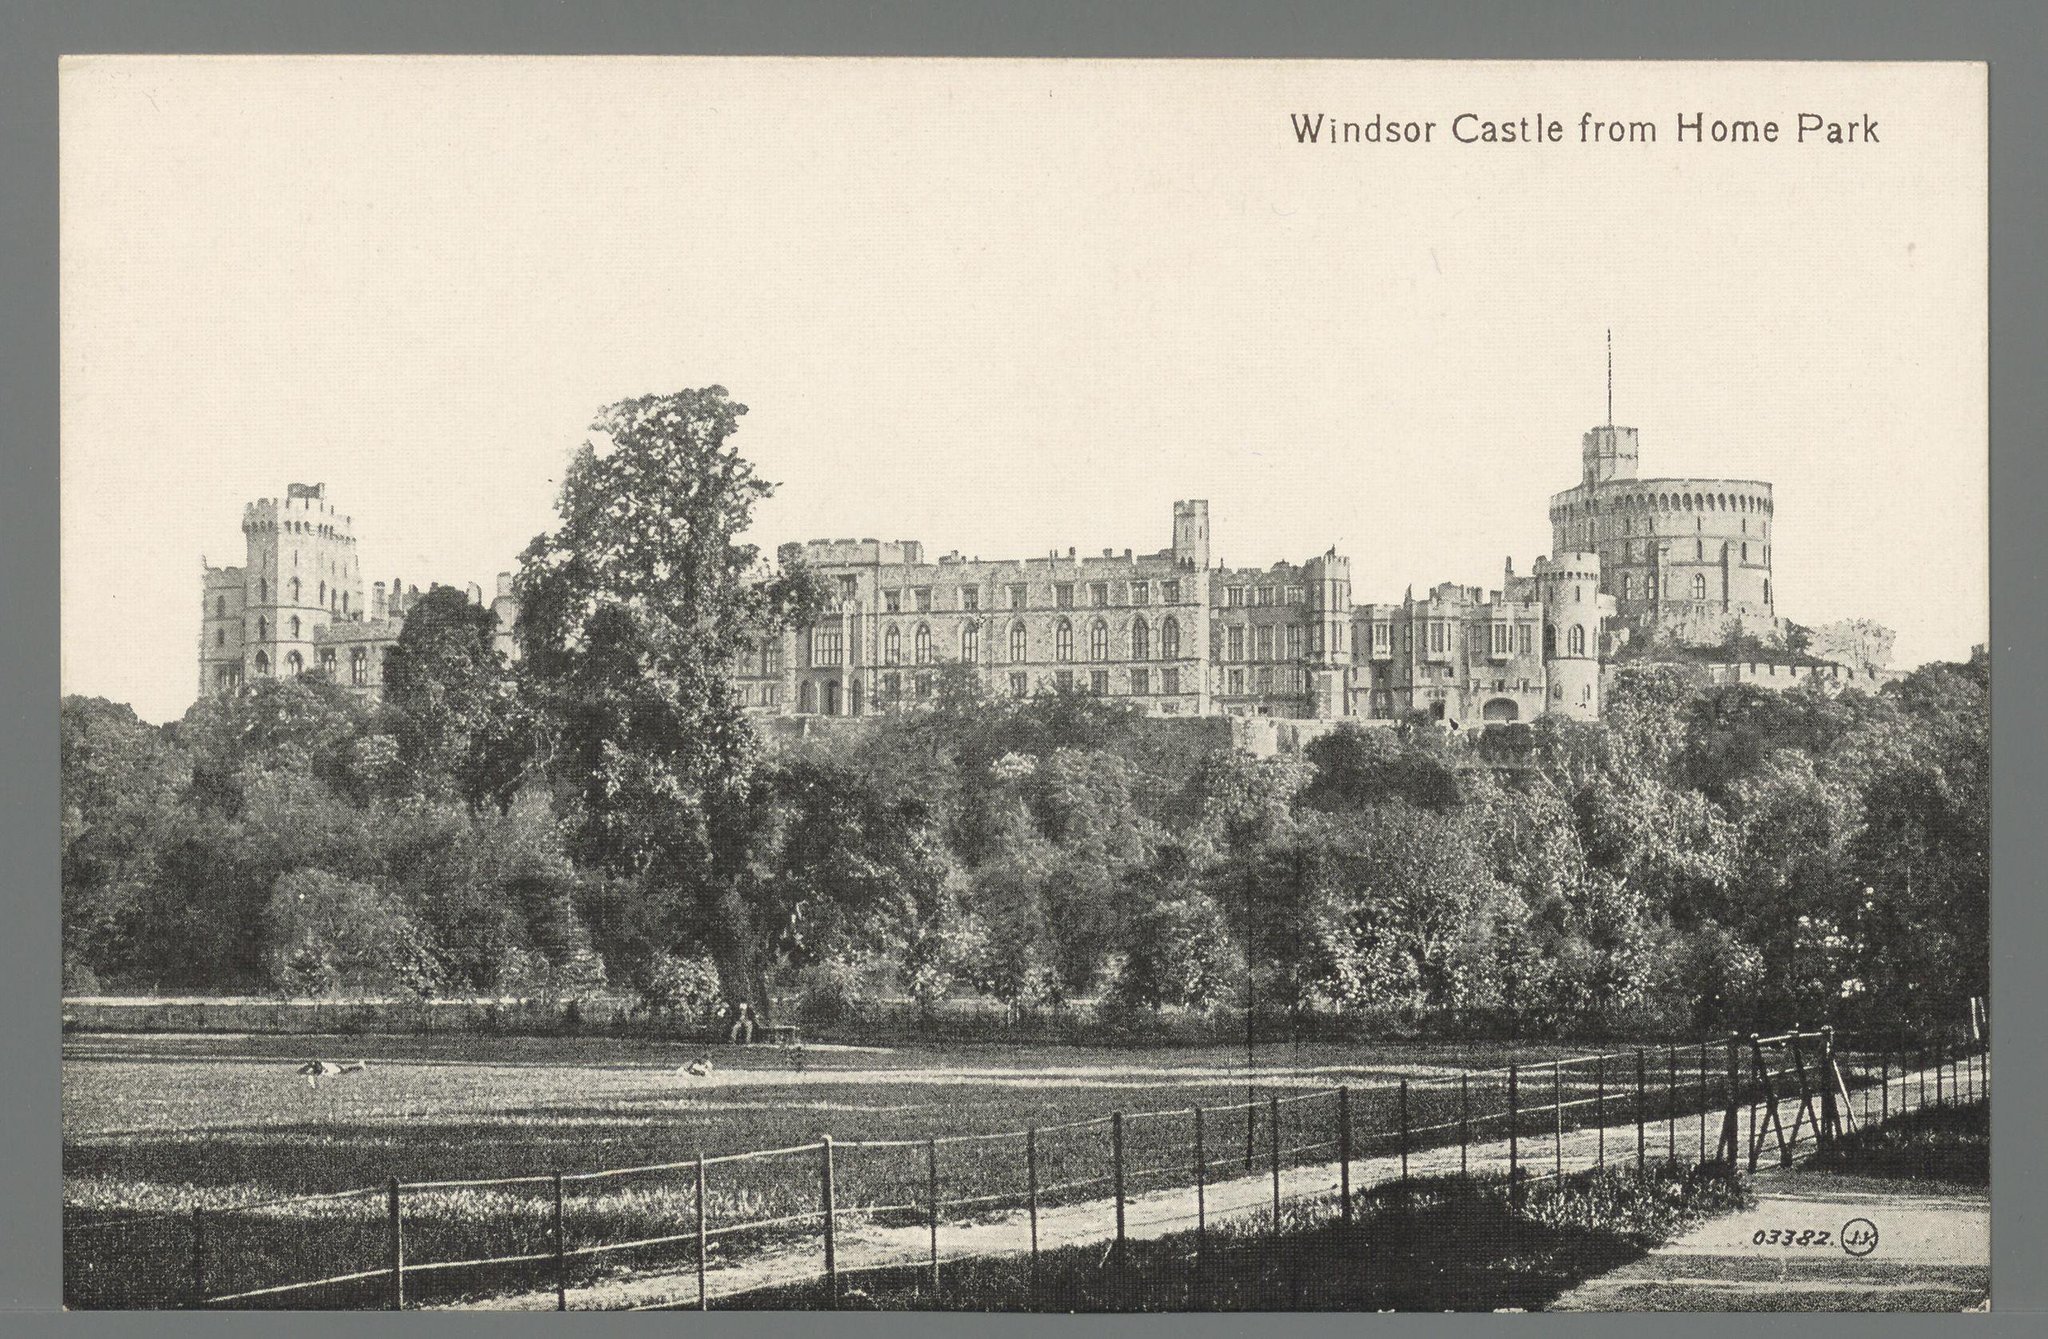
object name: photomechanical print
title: Windsor Castle from Home Park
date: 1902-1930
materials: cardboard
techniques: autotype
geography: great britain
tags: park, castle